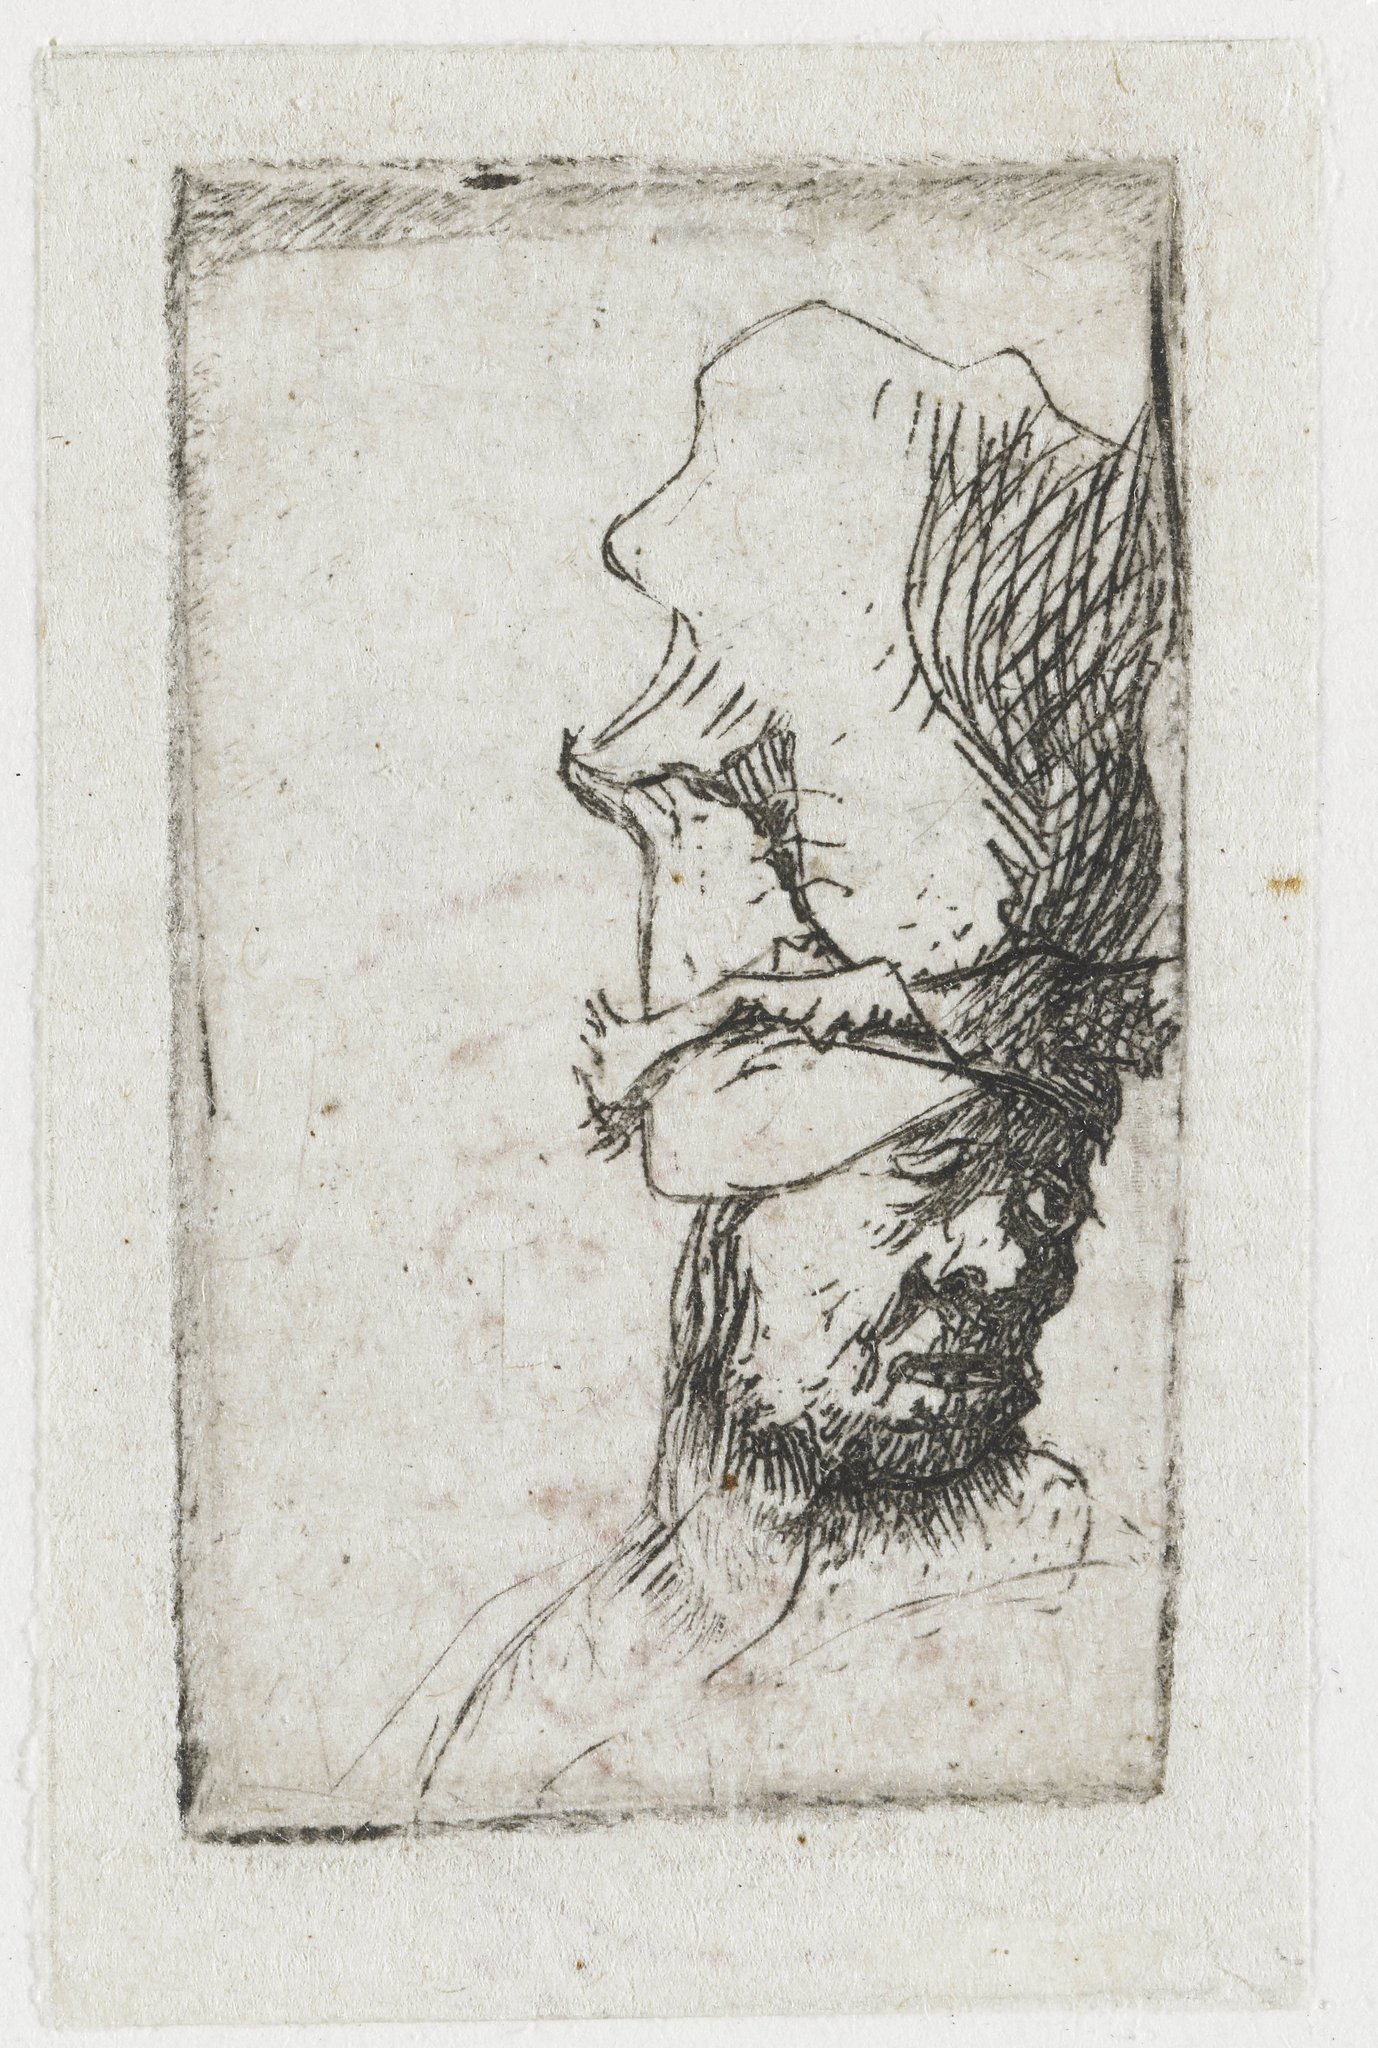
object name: print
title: Head of a man in a high cap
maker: rembrandt van rijn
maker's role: draughtsman, painter, print maker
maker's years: 1606-1669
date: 1629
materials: paper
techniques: etching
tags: head-gear: cap (+ men's clothes)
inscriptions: collector's mark: Lugt 240